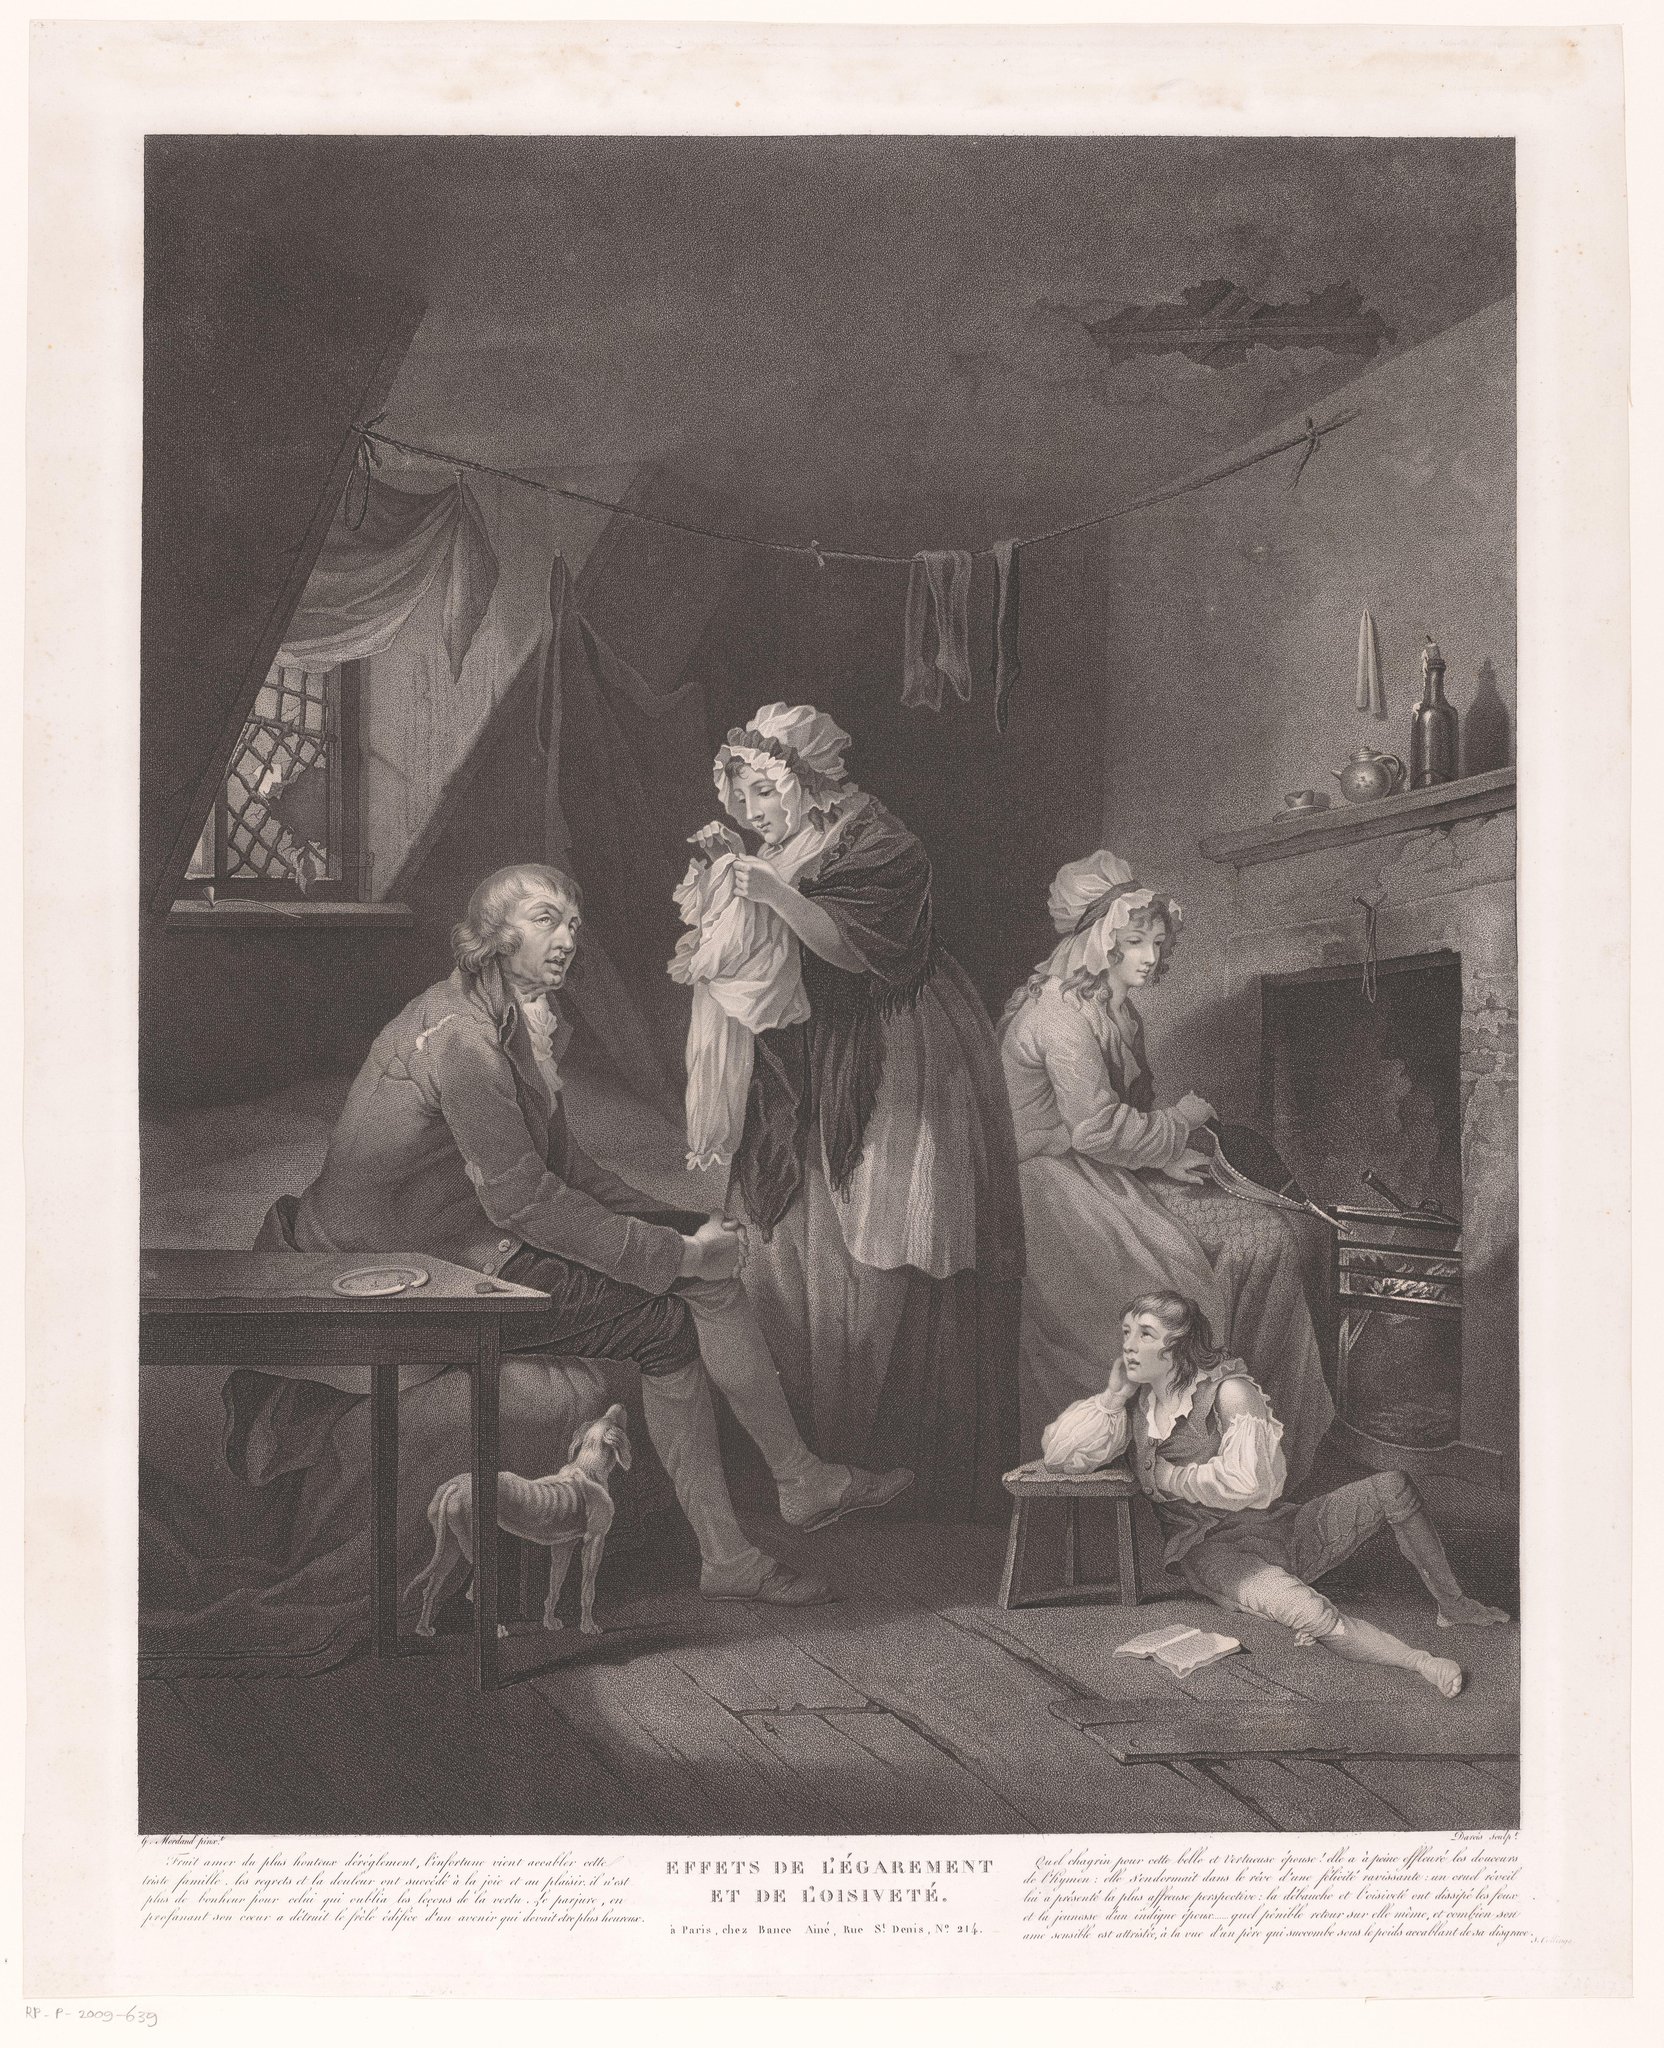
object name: print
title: Vier figuren in een vervallen huiskamer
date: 1787-1801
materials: paper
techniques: engraving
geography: paris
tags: open hearth, fire-place, family, relationship, descent, the poor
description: Vier figuren, waarschijnlijk een gezin in een vervallen kamer voor een haard. Volgens de titel op het object betreft dit een situatie ontstaan uit luiheid en afleiding. Onder de afbeelding negen regels Franse tekst.